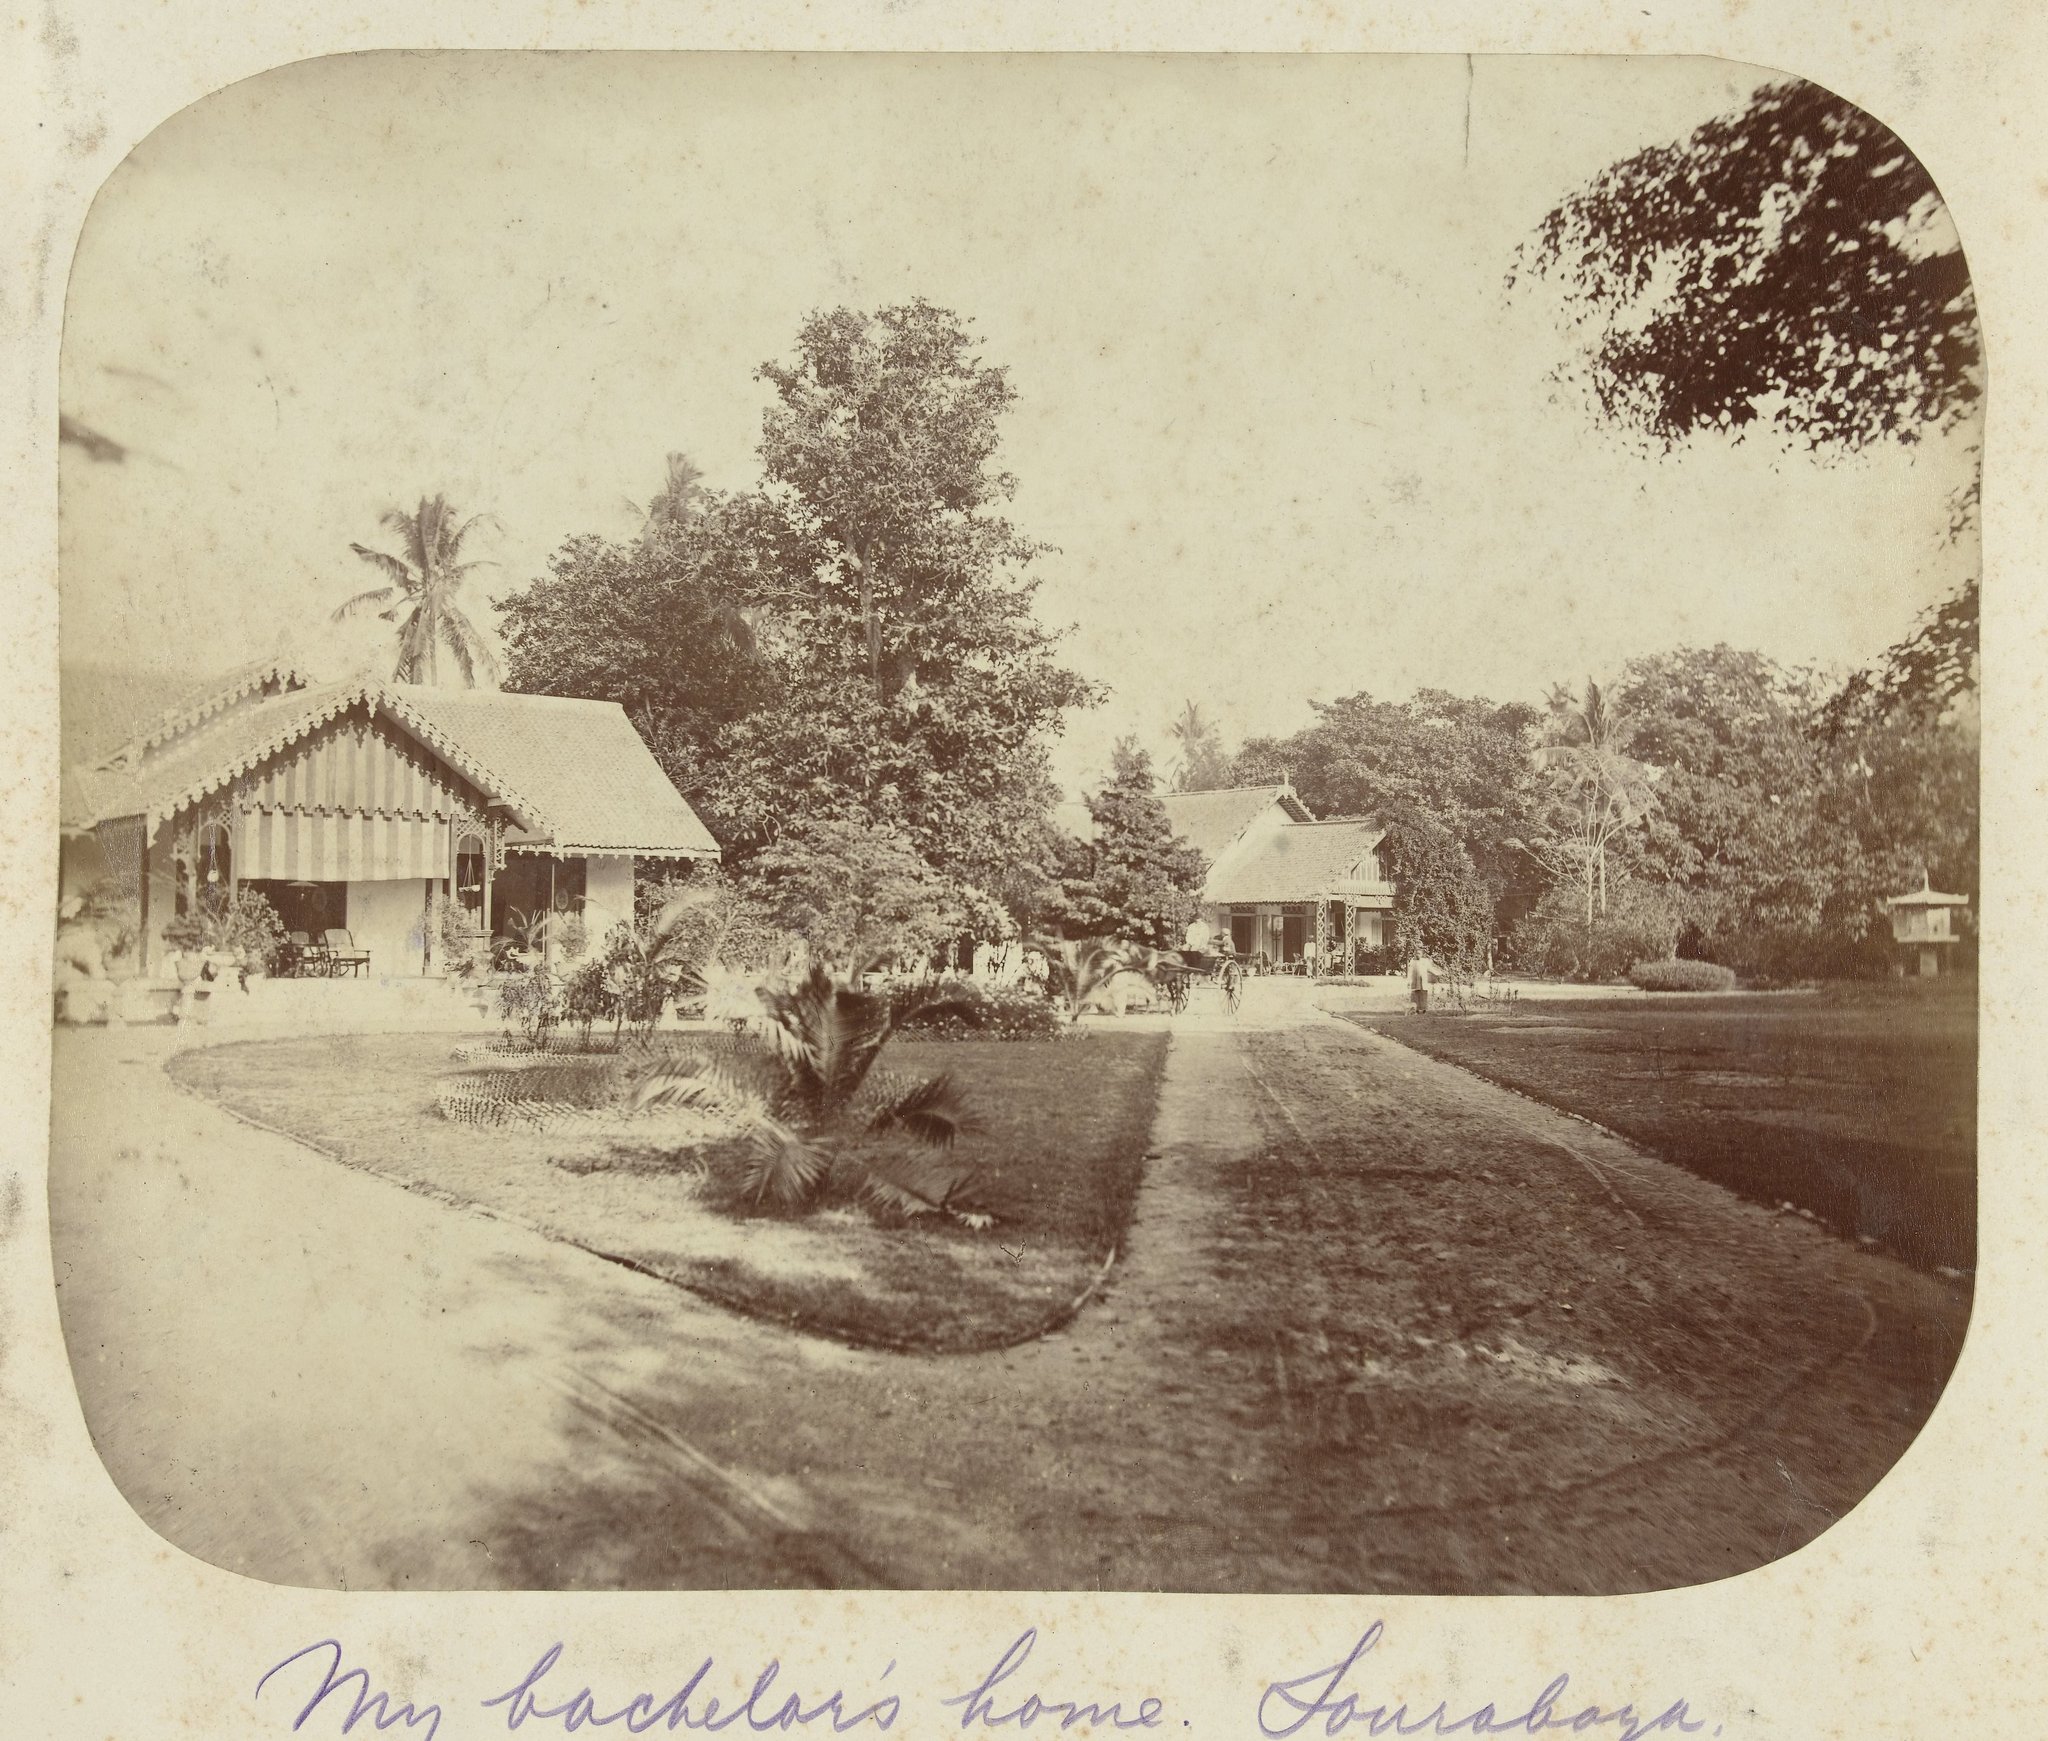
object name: photograph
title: Twee woningen gelegen aan een grindpad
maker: Anonymous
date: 1890-1910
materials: cardboard, paper, photographic support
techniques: gelatin silver print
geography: netherlands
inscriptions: caption: ‘My bachelor's home. Soerabaya’